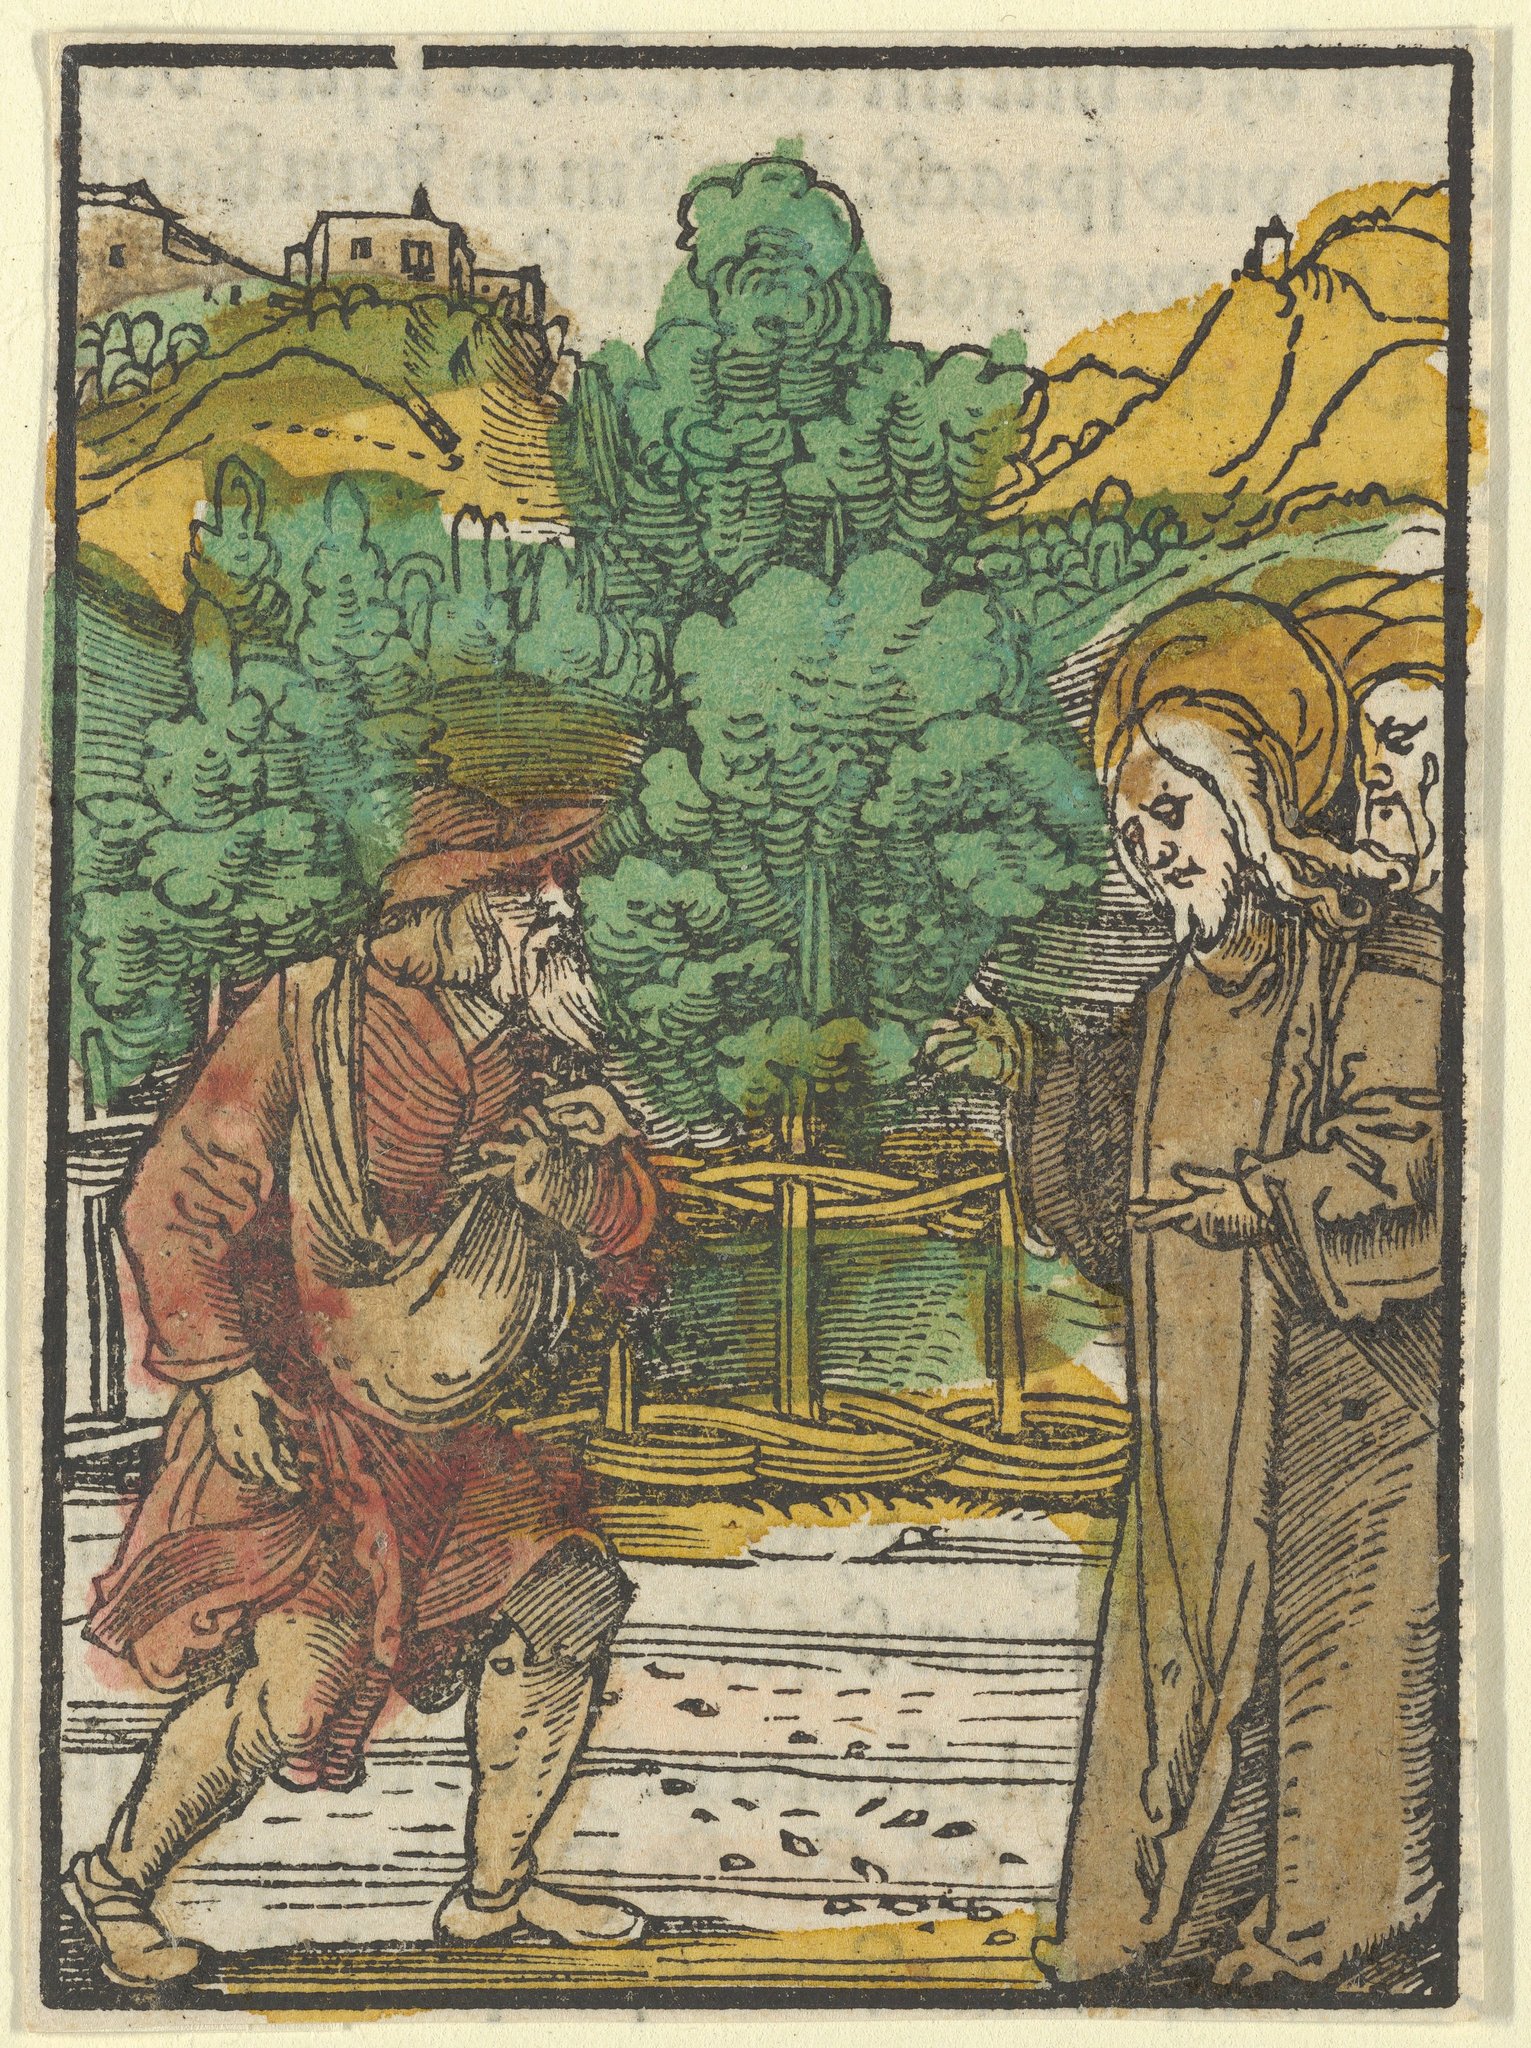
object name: print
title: The Parable and the Sower, from Das Plenarium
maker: hans schäufelein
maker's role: artist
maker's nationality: german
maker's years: 1480-1540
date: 1517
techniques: hand coloring, woodcut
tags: men,jesus